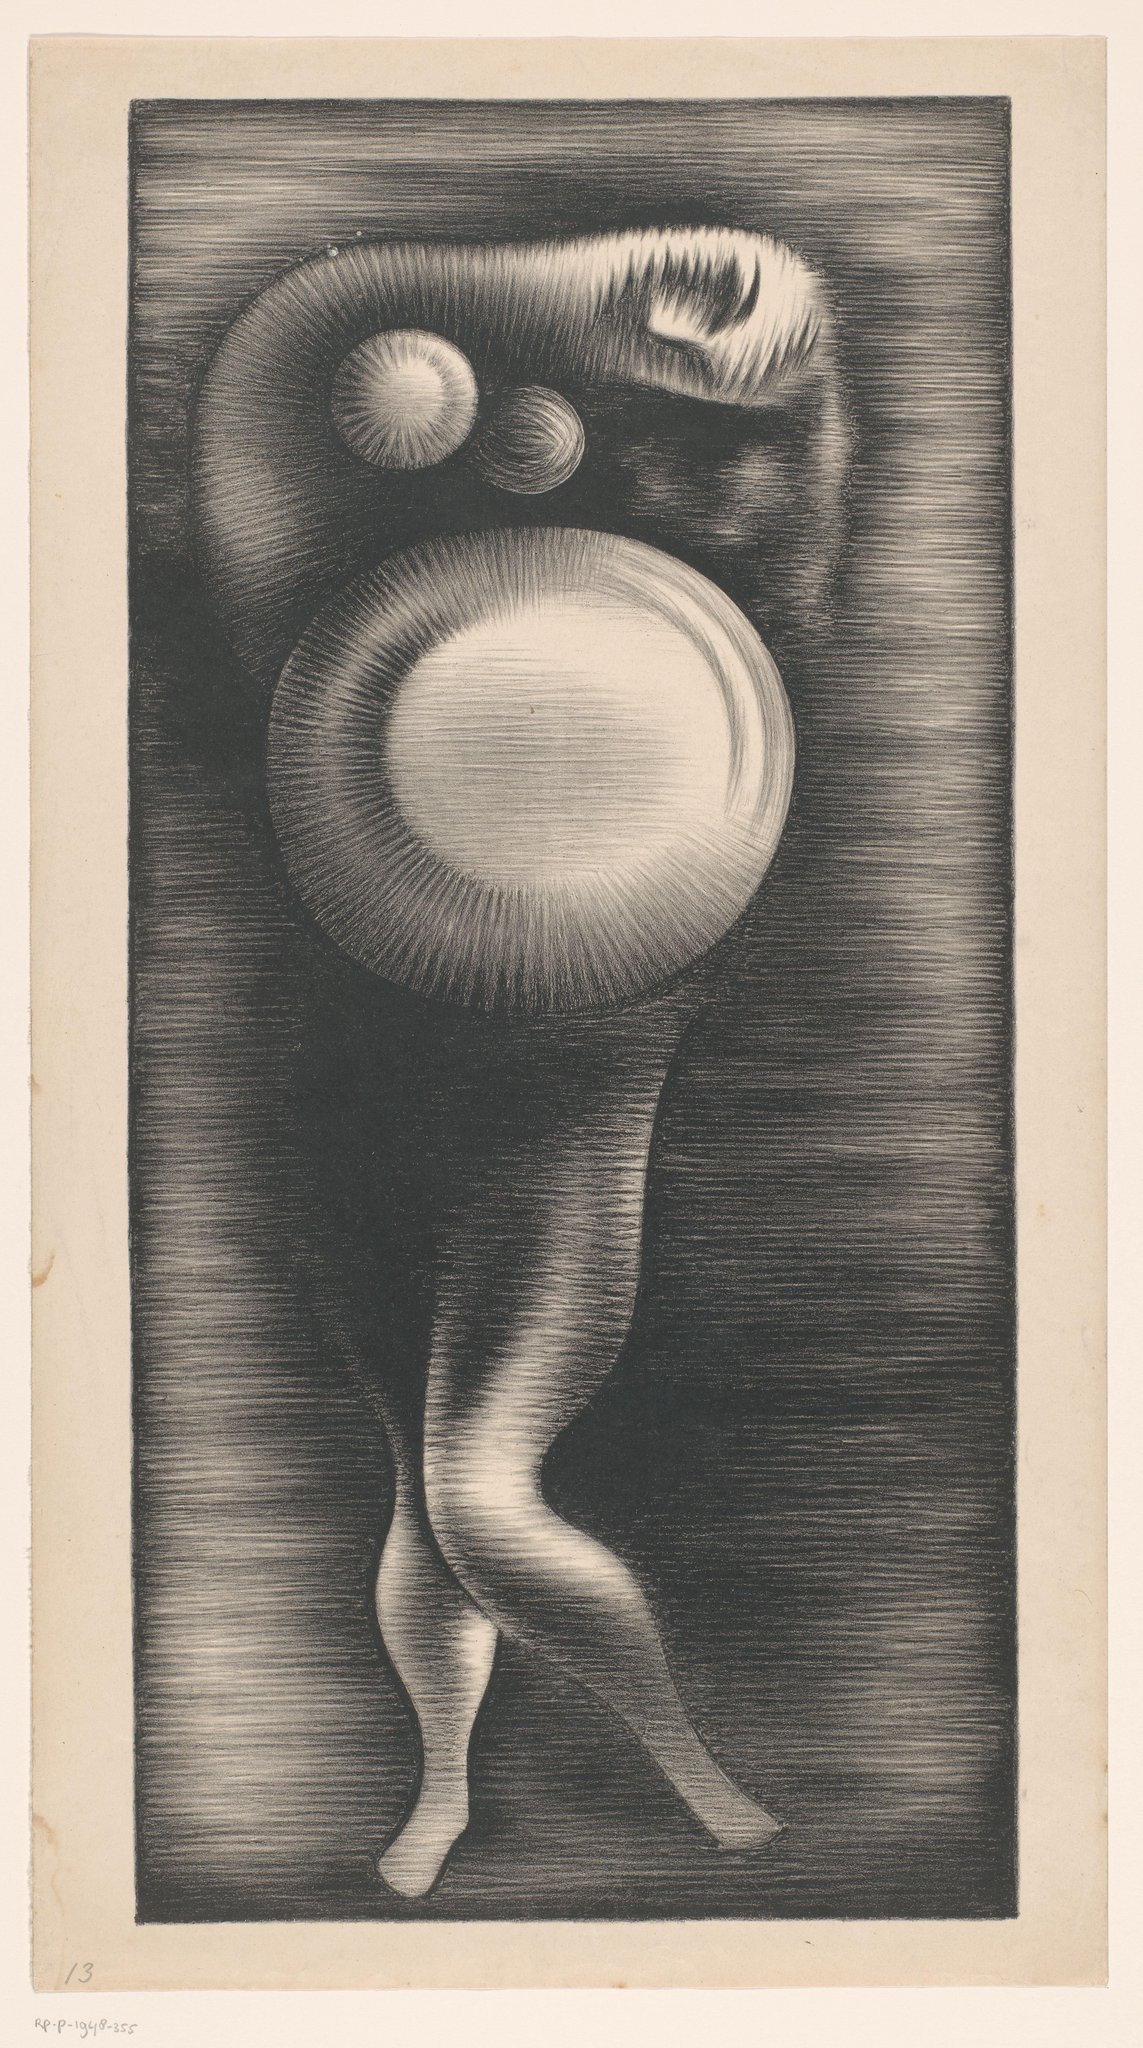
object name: print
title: Gedeformeerd vrouwenlichaam met drie cirkels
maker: jacob bendien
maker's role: draughtsman, print maker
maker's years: 1890-1933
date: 1900-1933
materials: paper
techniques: lithograph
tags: legs - aa - female human figure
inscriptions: collector's mark: Lugt 2228, inscription: ‘13’